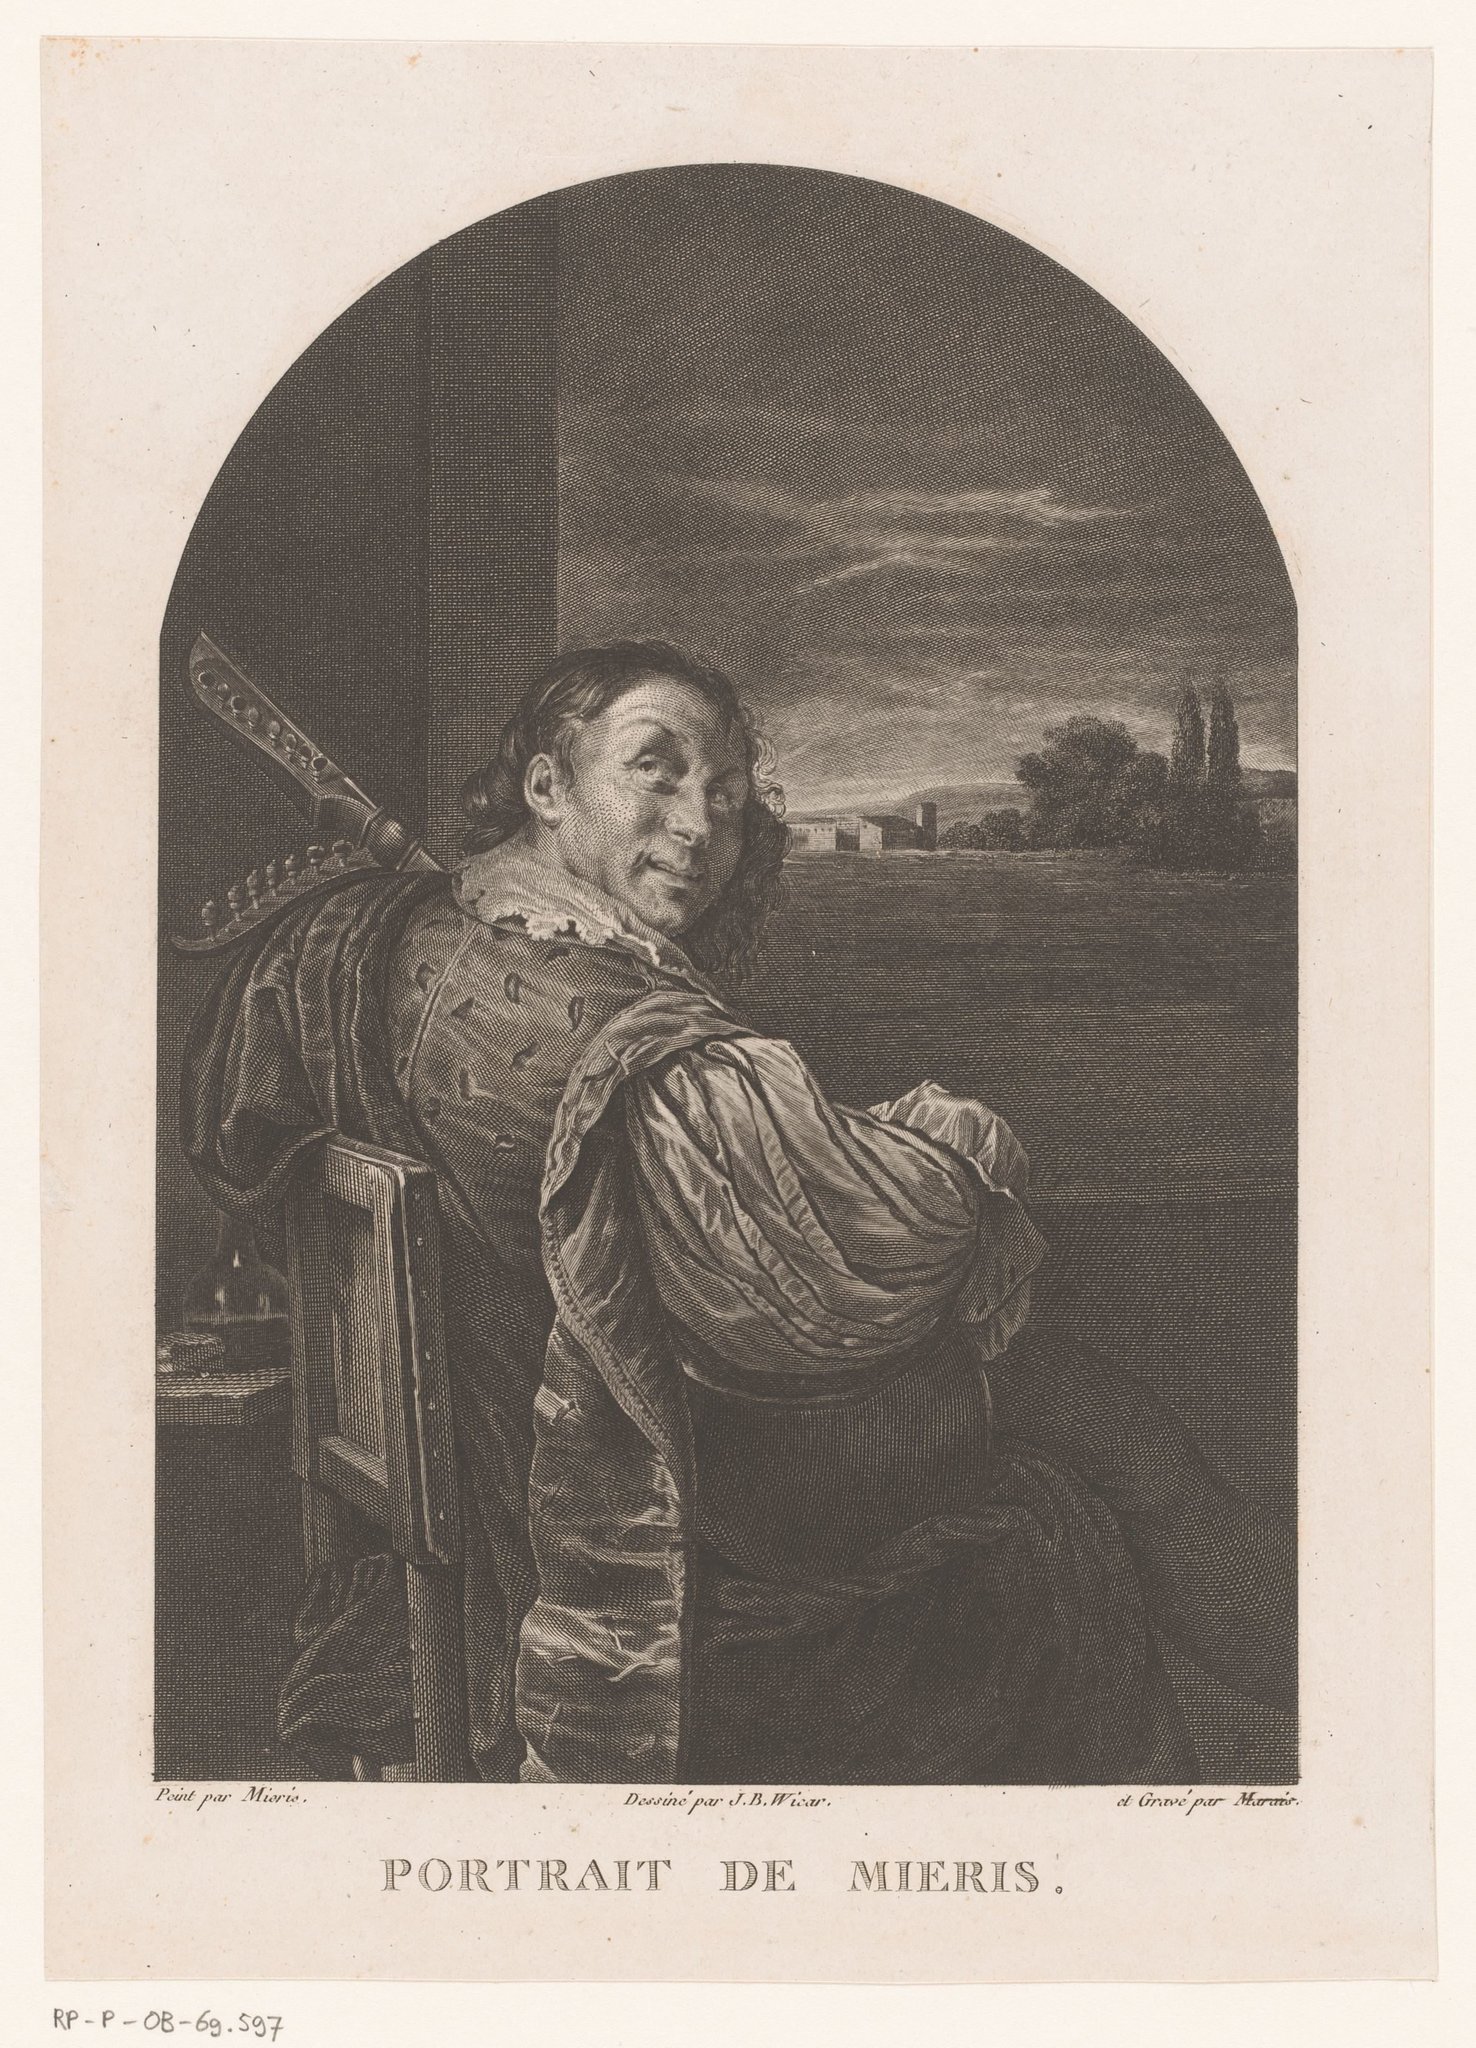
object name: print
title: Portrait de Mieris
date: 1780-1840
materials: paper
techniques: engraving, etching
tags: frans van mieris, historical persons, portrait, self-portrait of painter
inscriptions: collector's mark: Lugt 2228